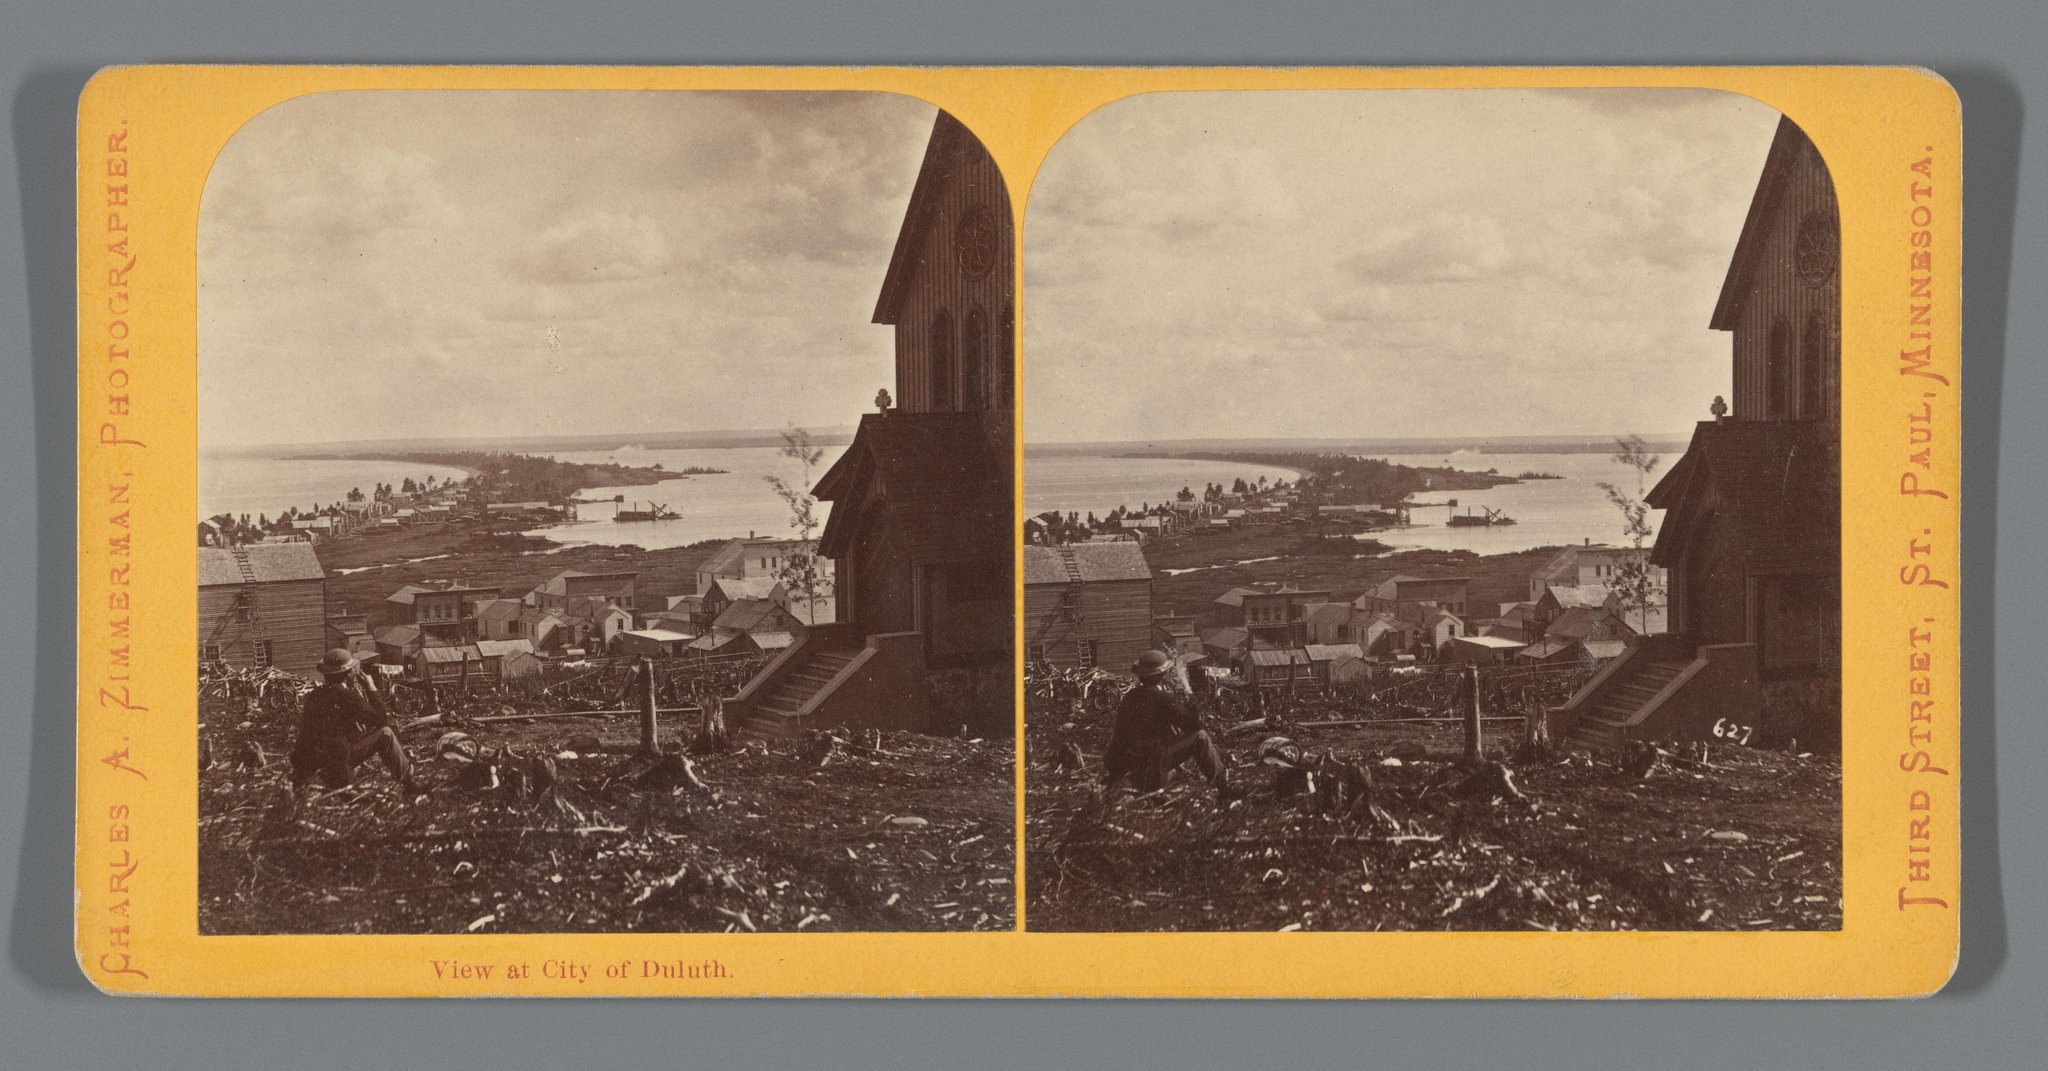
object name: stereograph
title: View at City of Duluth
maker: charles a. zimmerman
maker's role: fotograaf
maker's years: 1844-1909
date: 1860-1875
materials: cardboard, photographic support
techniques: albumen print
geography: saint paul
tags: prospect of village, silhouette of village, parts of church exterior and annexes, historical persons not known by name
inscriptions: number: ‘627’, number: ‘140,-’